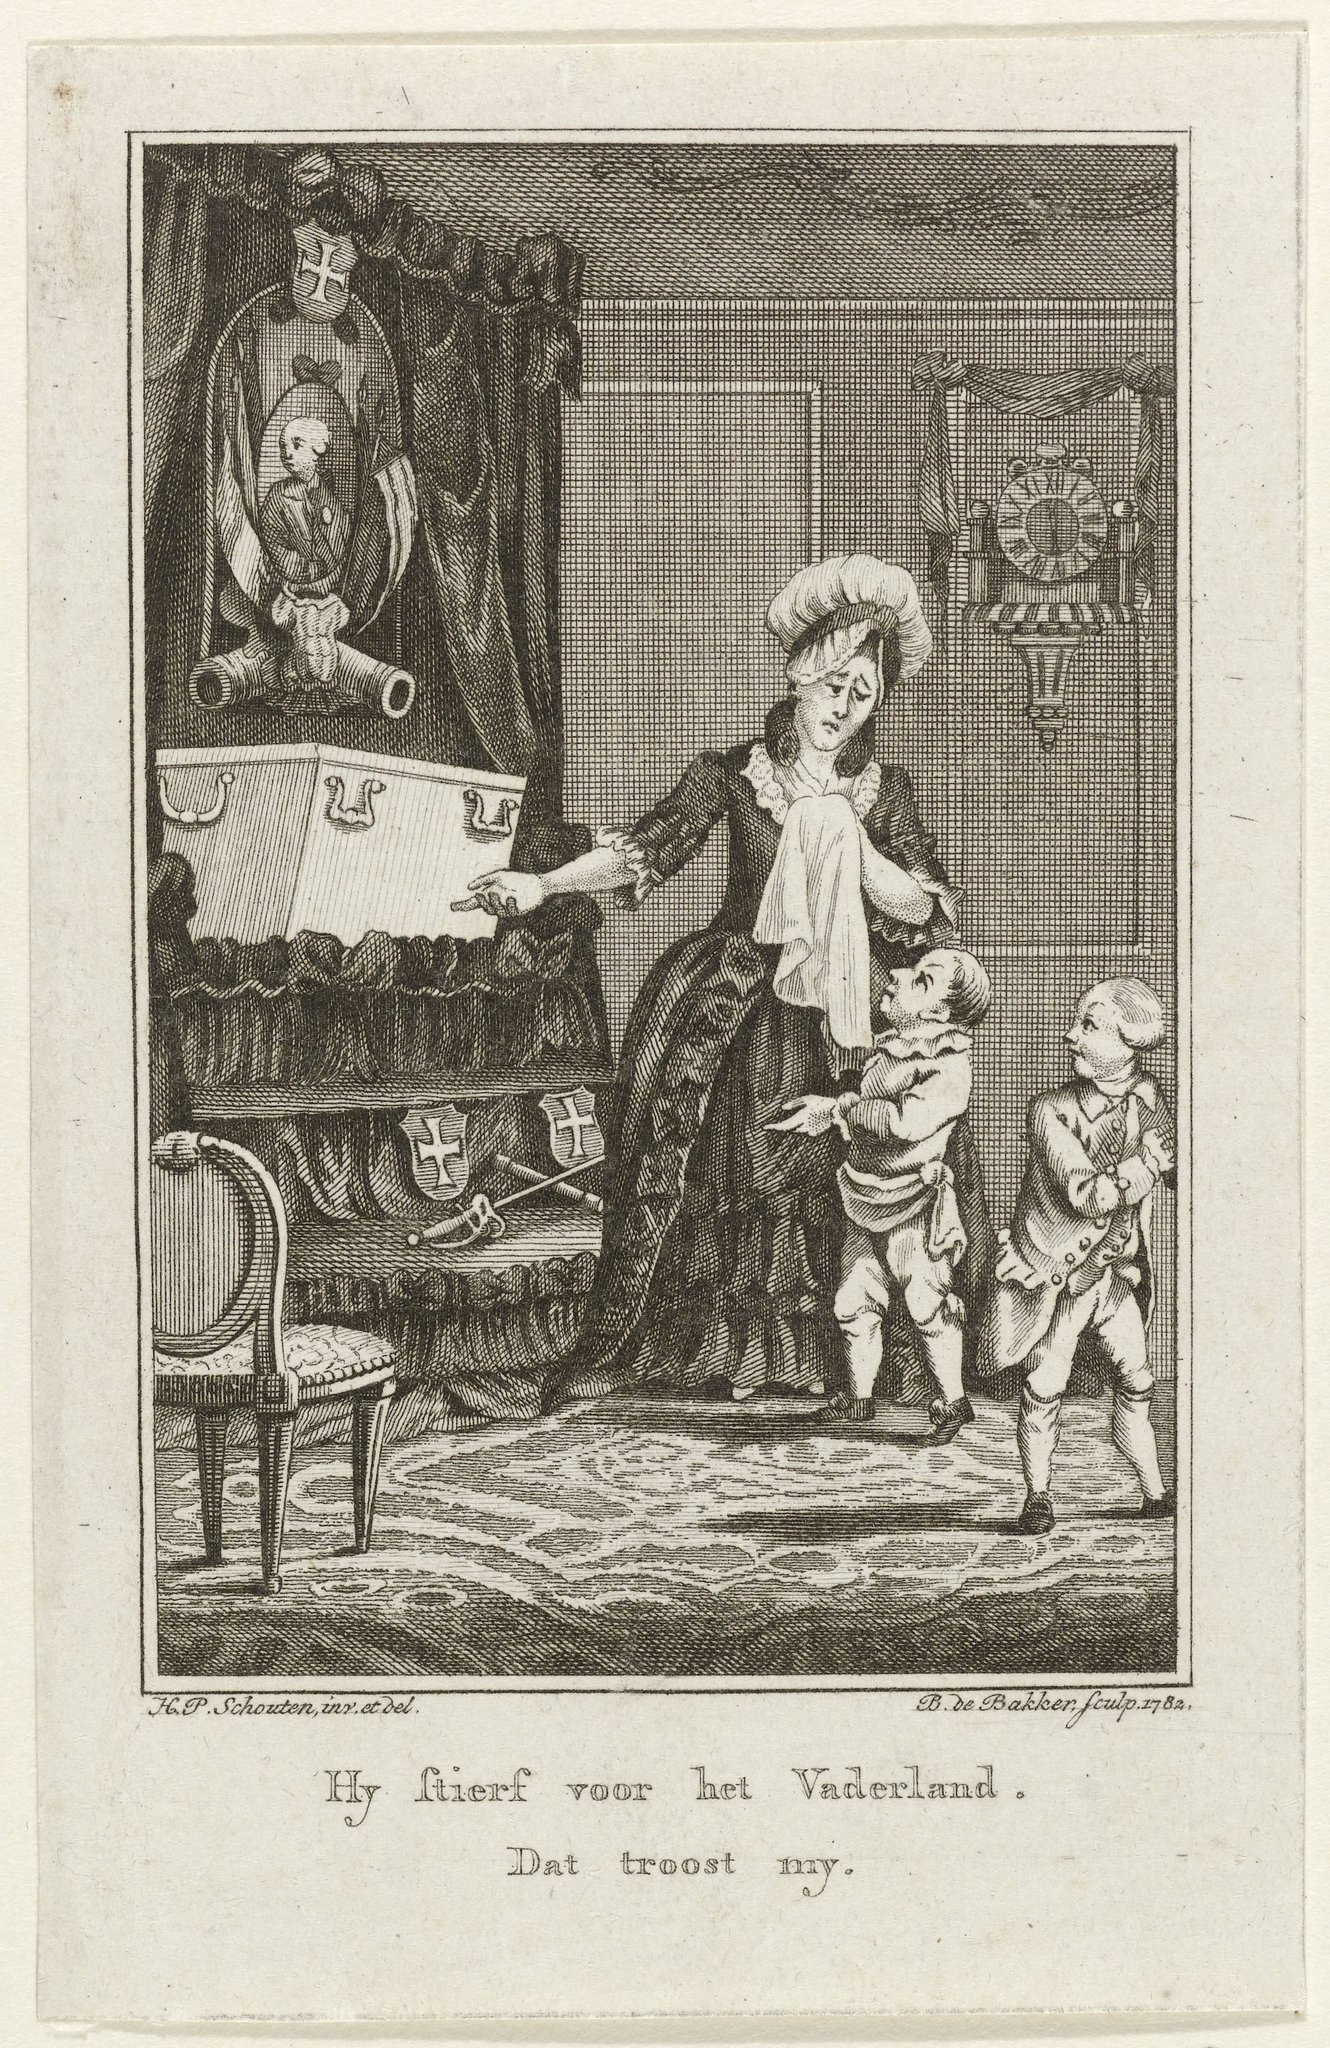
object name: print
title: Hy stierf voor het Vaderland. / Dat troost my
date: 1782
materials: paper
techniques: etching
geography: northern netherlands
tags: amsterdam, widow, burial rites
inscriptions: collector's mark: Lugt 2228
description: De weduwe van Wolter Jan Gerrit baron Bentinck met haar beide kinderen in een huiskamer bij de lijkbaar van haar echtgenoot, gestorven 23/24 november 1781.